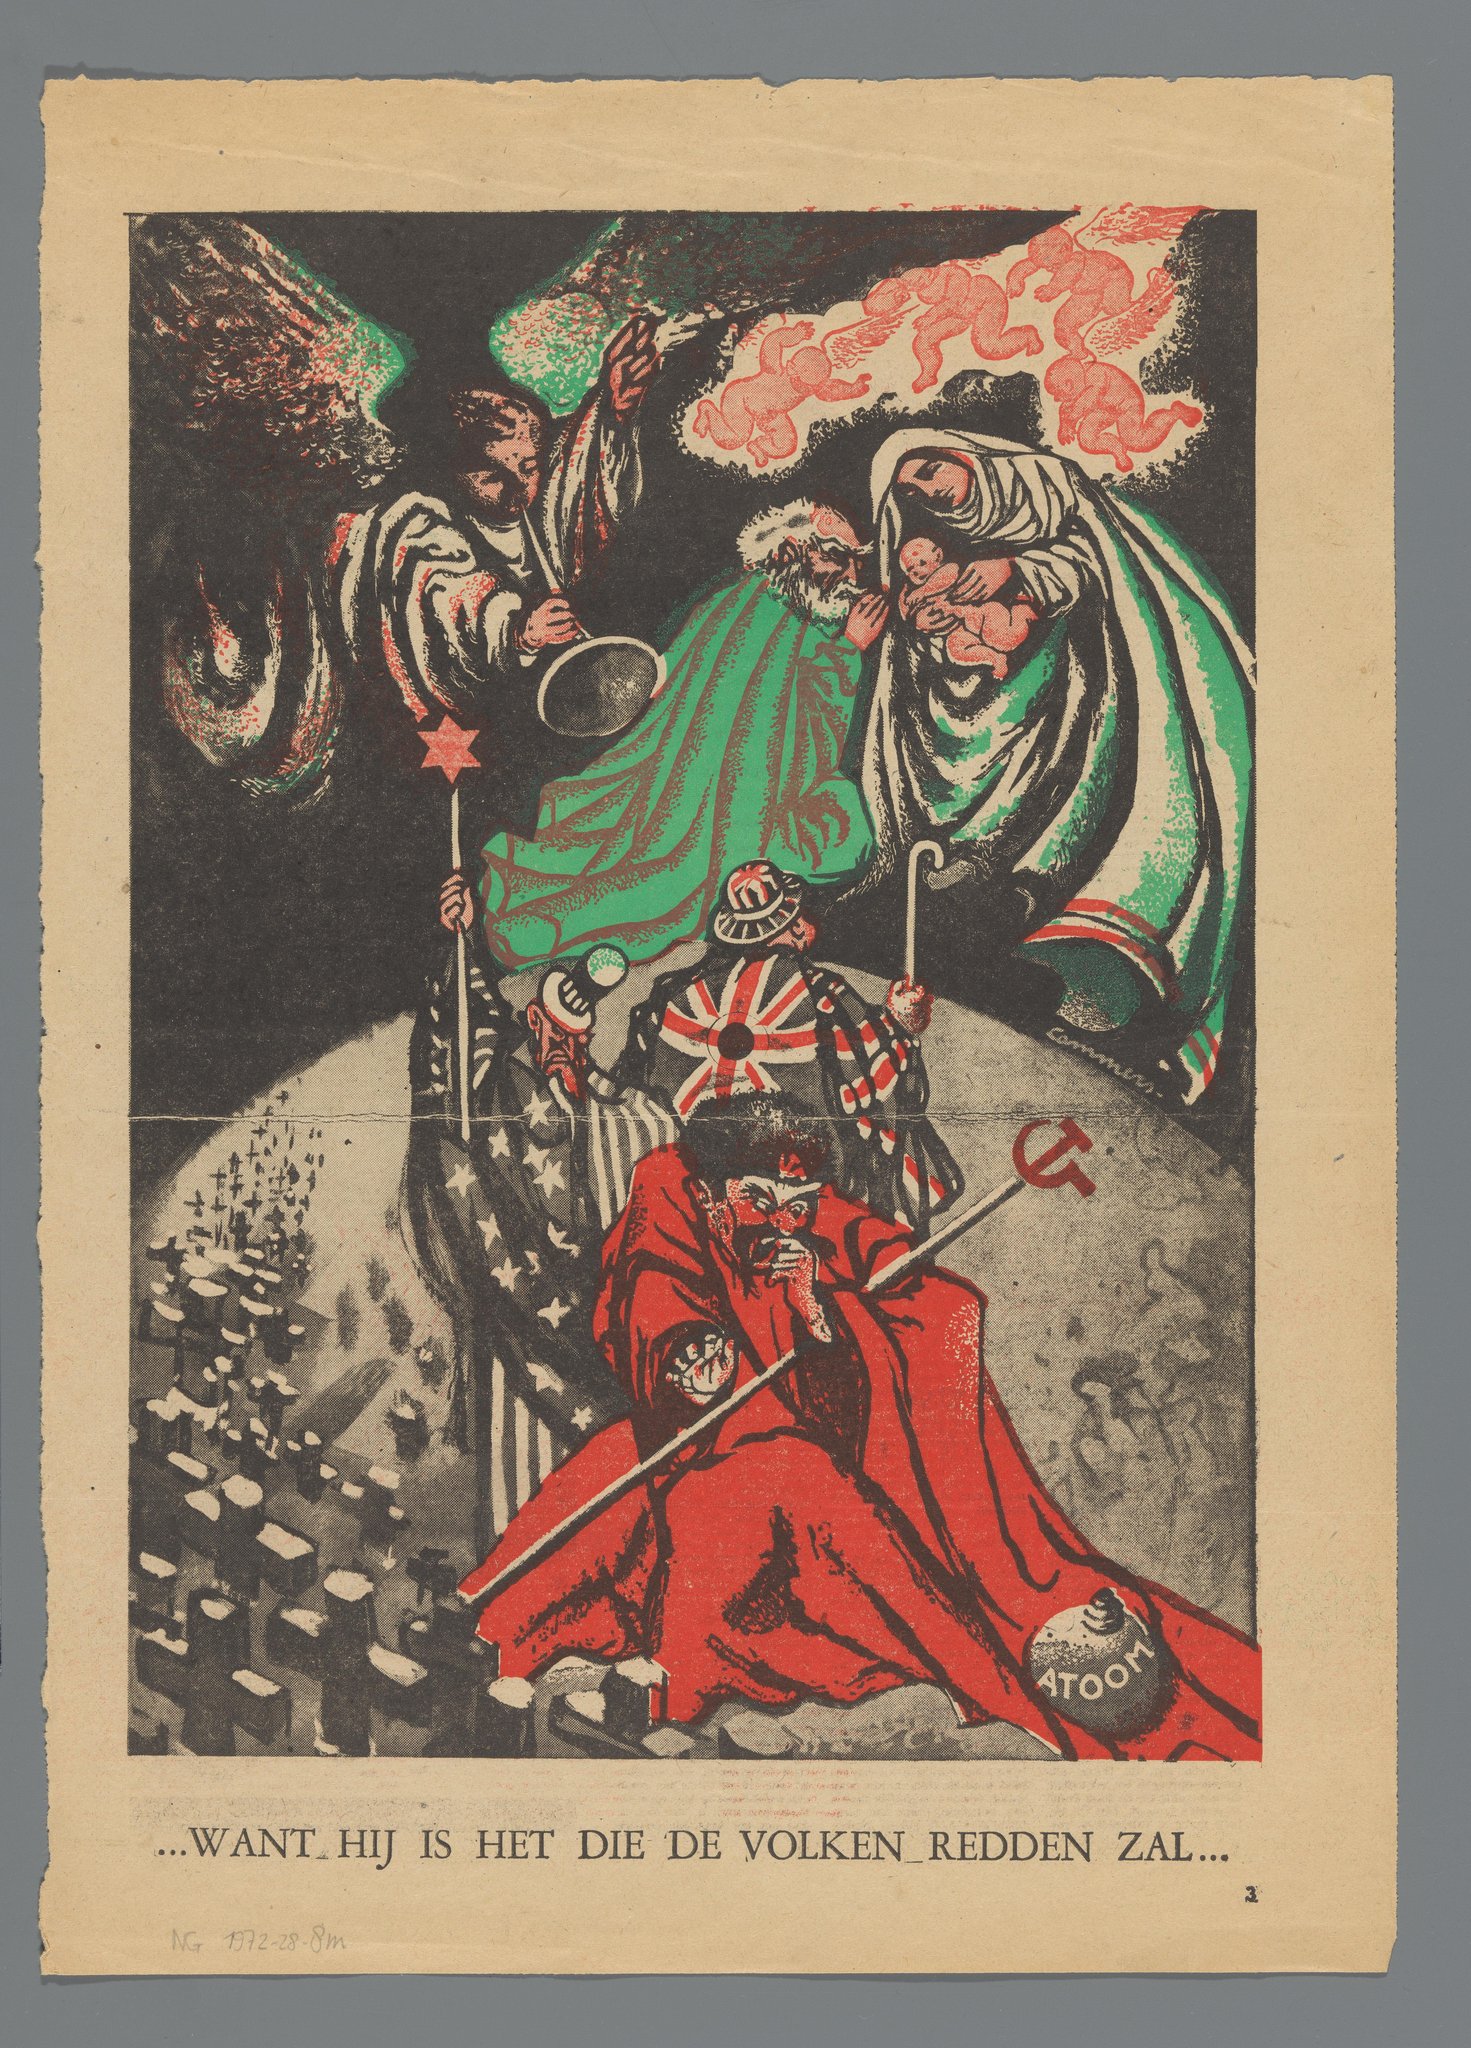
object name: photomechanical print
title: ...Want hij is het die volken redden zal...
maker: lammers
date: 1945-1948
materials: paper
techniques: offset printed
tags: the story of the three wise men (kings or magi) (matthew 2:1-12), nuclear, biological and chemical weapons, united kingdom, united states of america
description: Pagina uit een tijdschrift of krant met een spotprent waarin de Sovjet-Unie, de Verenigde Staten en het Verenigd Koninkrijk zich als de drie wijzen uit het oosten in afschuw afkeren van de atoombom en op aanwijzing van een engel lopen richting het Christuskind.